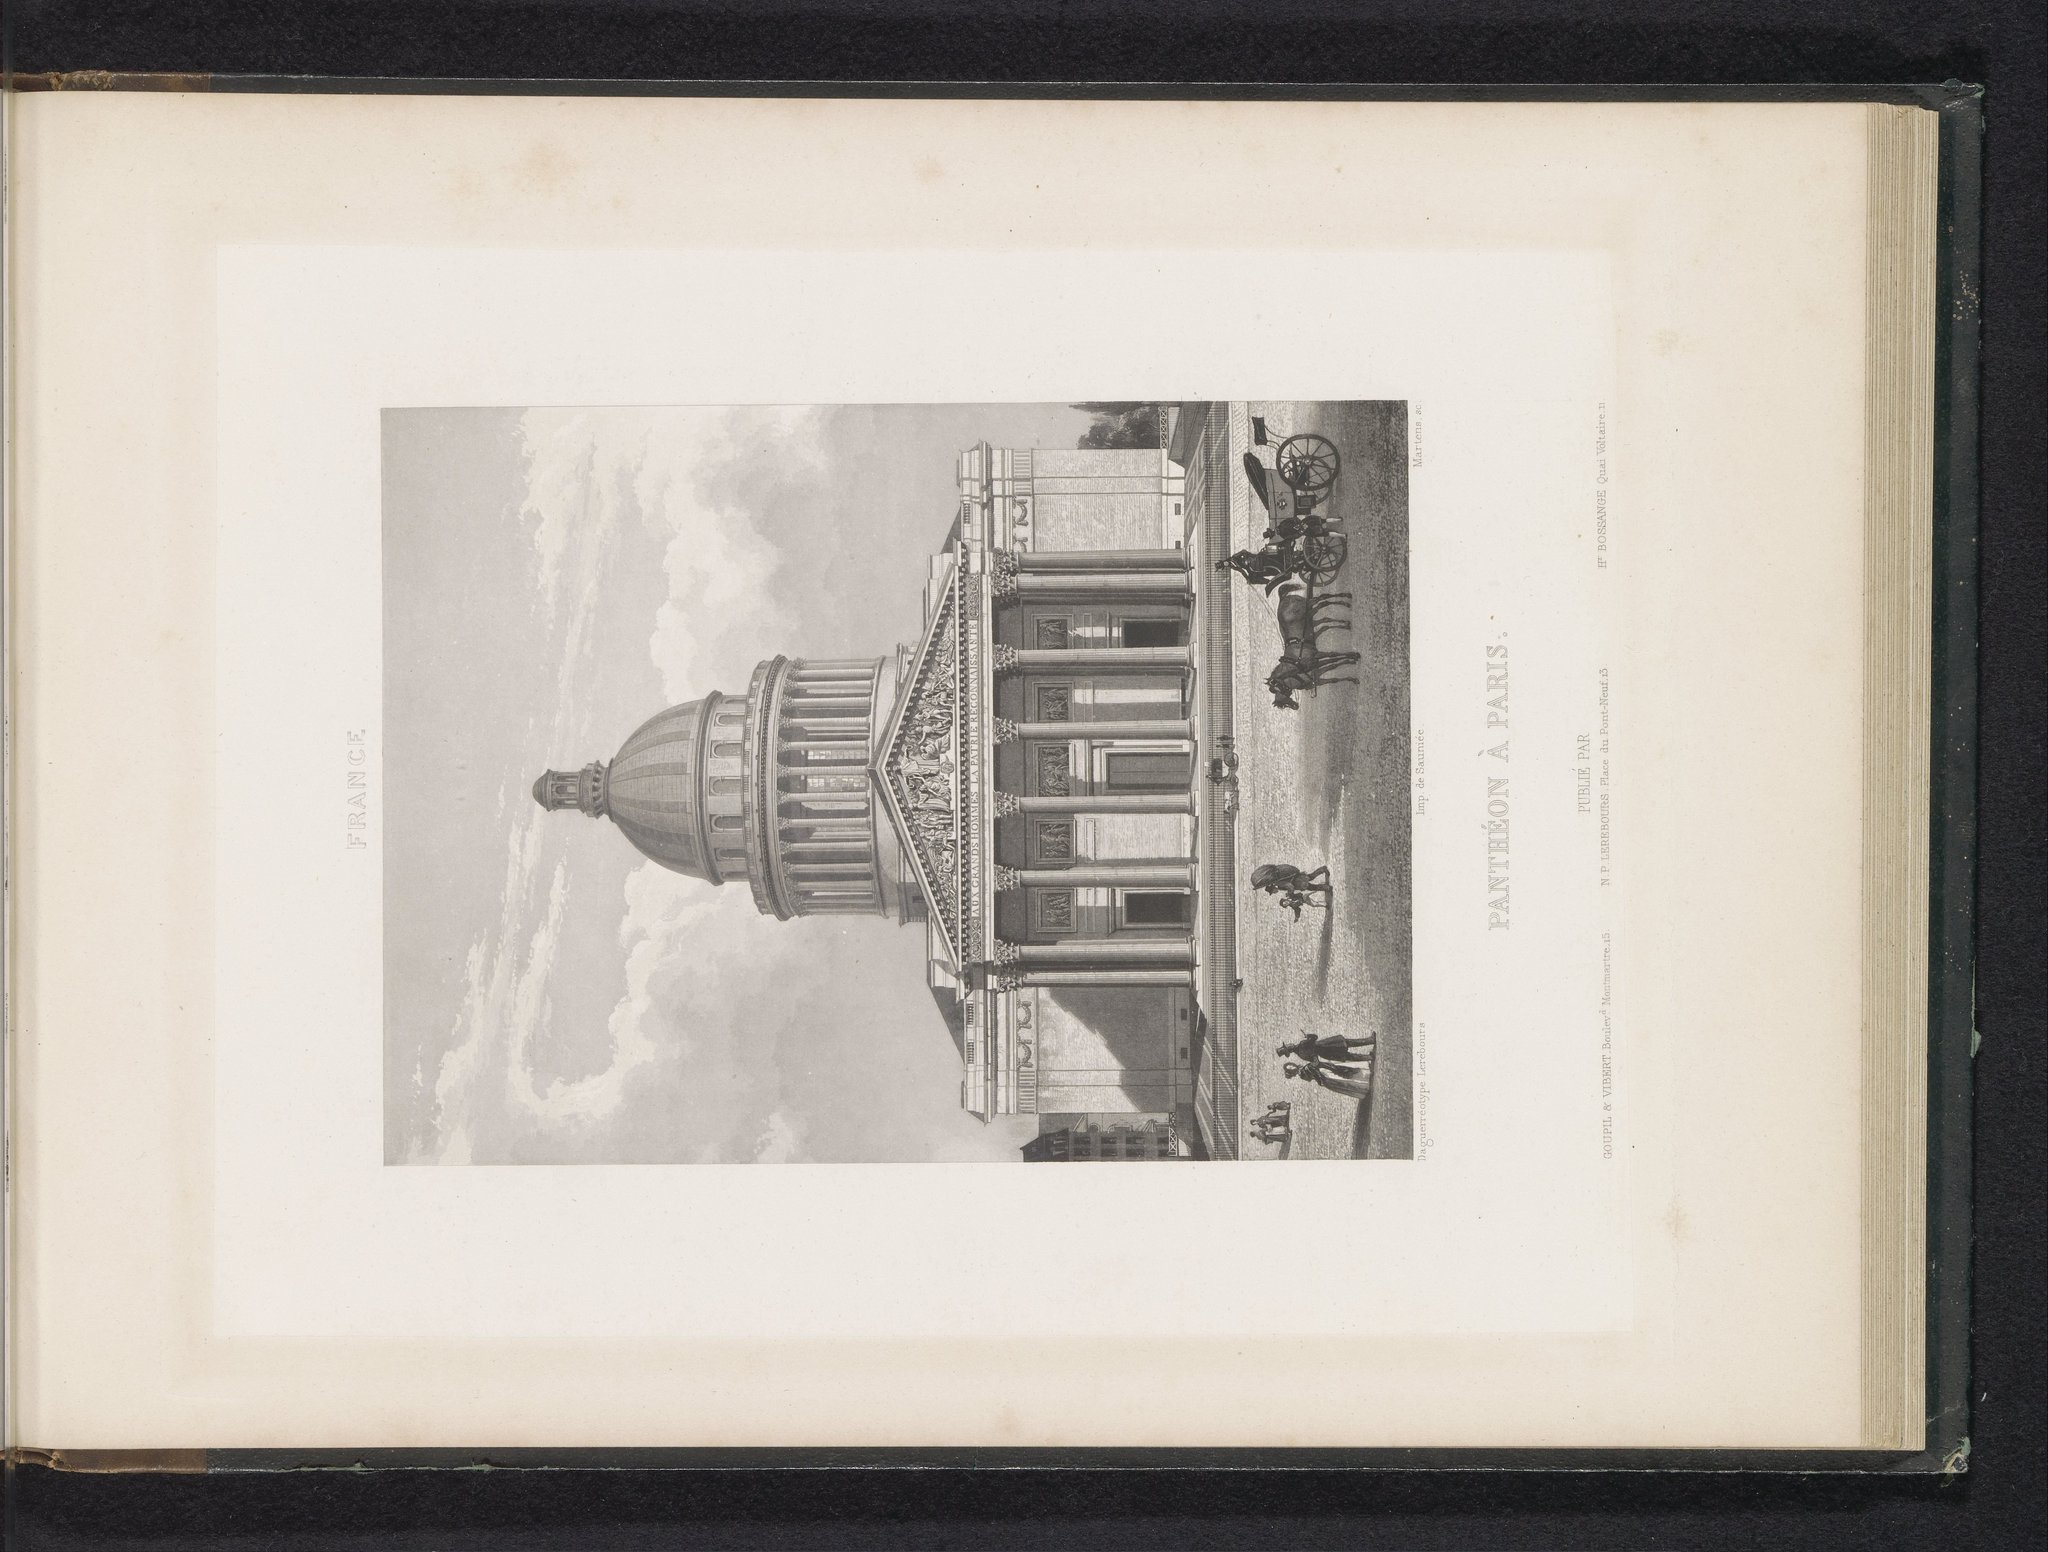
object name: print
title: Panthéon à Paris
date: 1839-1841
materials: paper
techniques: aquatint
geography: paris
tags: façade (of house or building), dome ~ architecture, grave, tomb and other grave-forms and grave-markers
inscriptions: inscription: ‘N.P. Lerebours Place du Pont Neuf 15’, inscription: ‘Rittner & Goupil Boulevd Montmartre 15’, inscription: ‘Hr. Bossance Quai Voltaire 11’